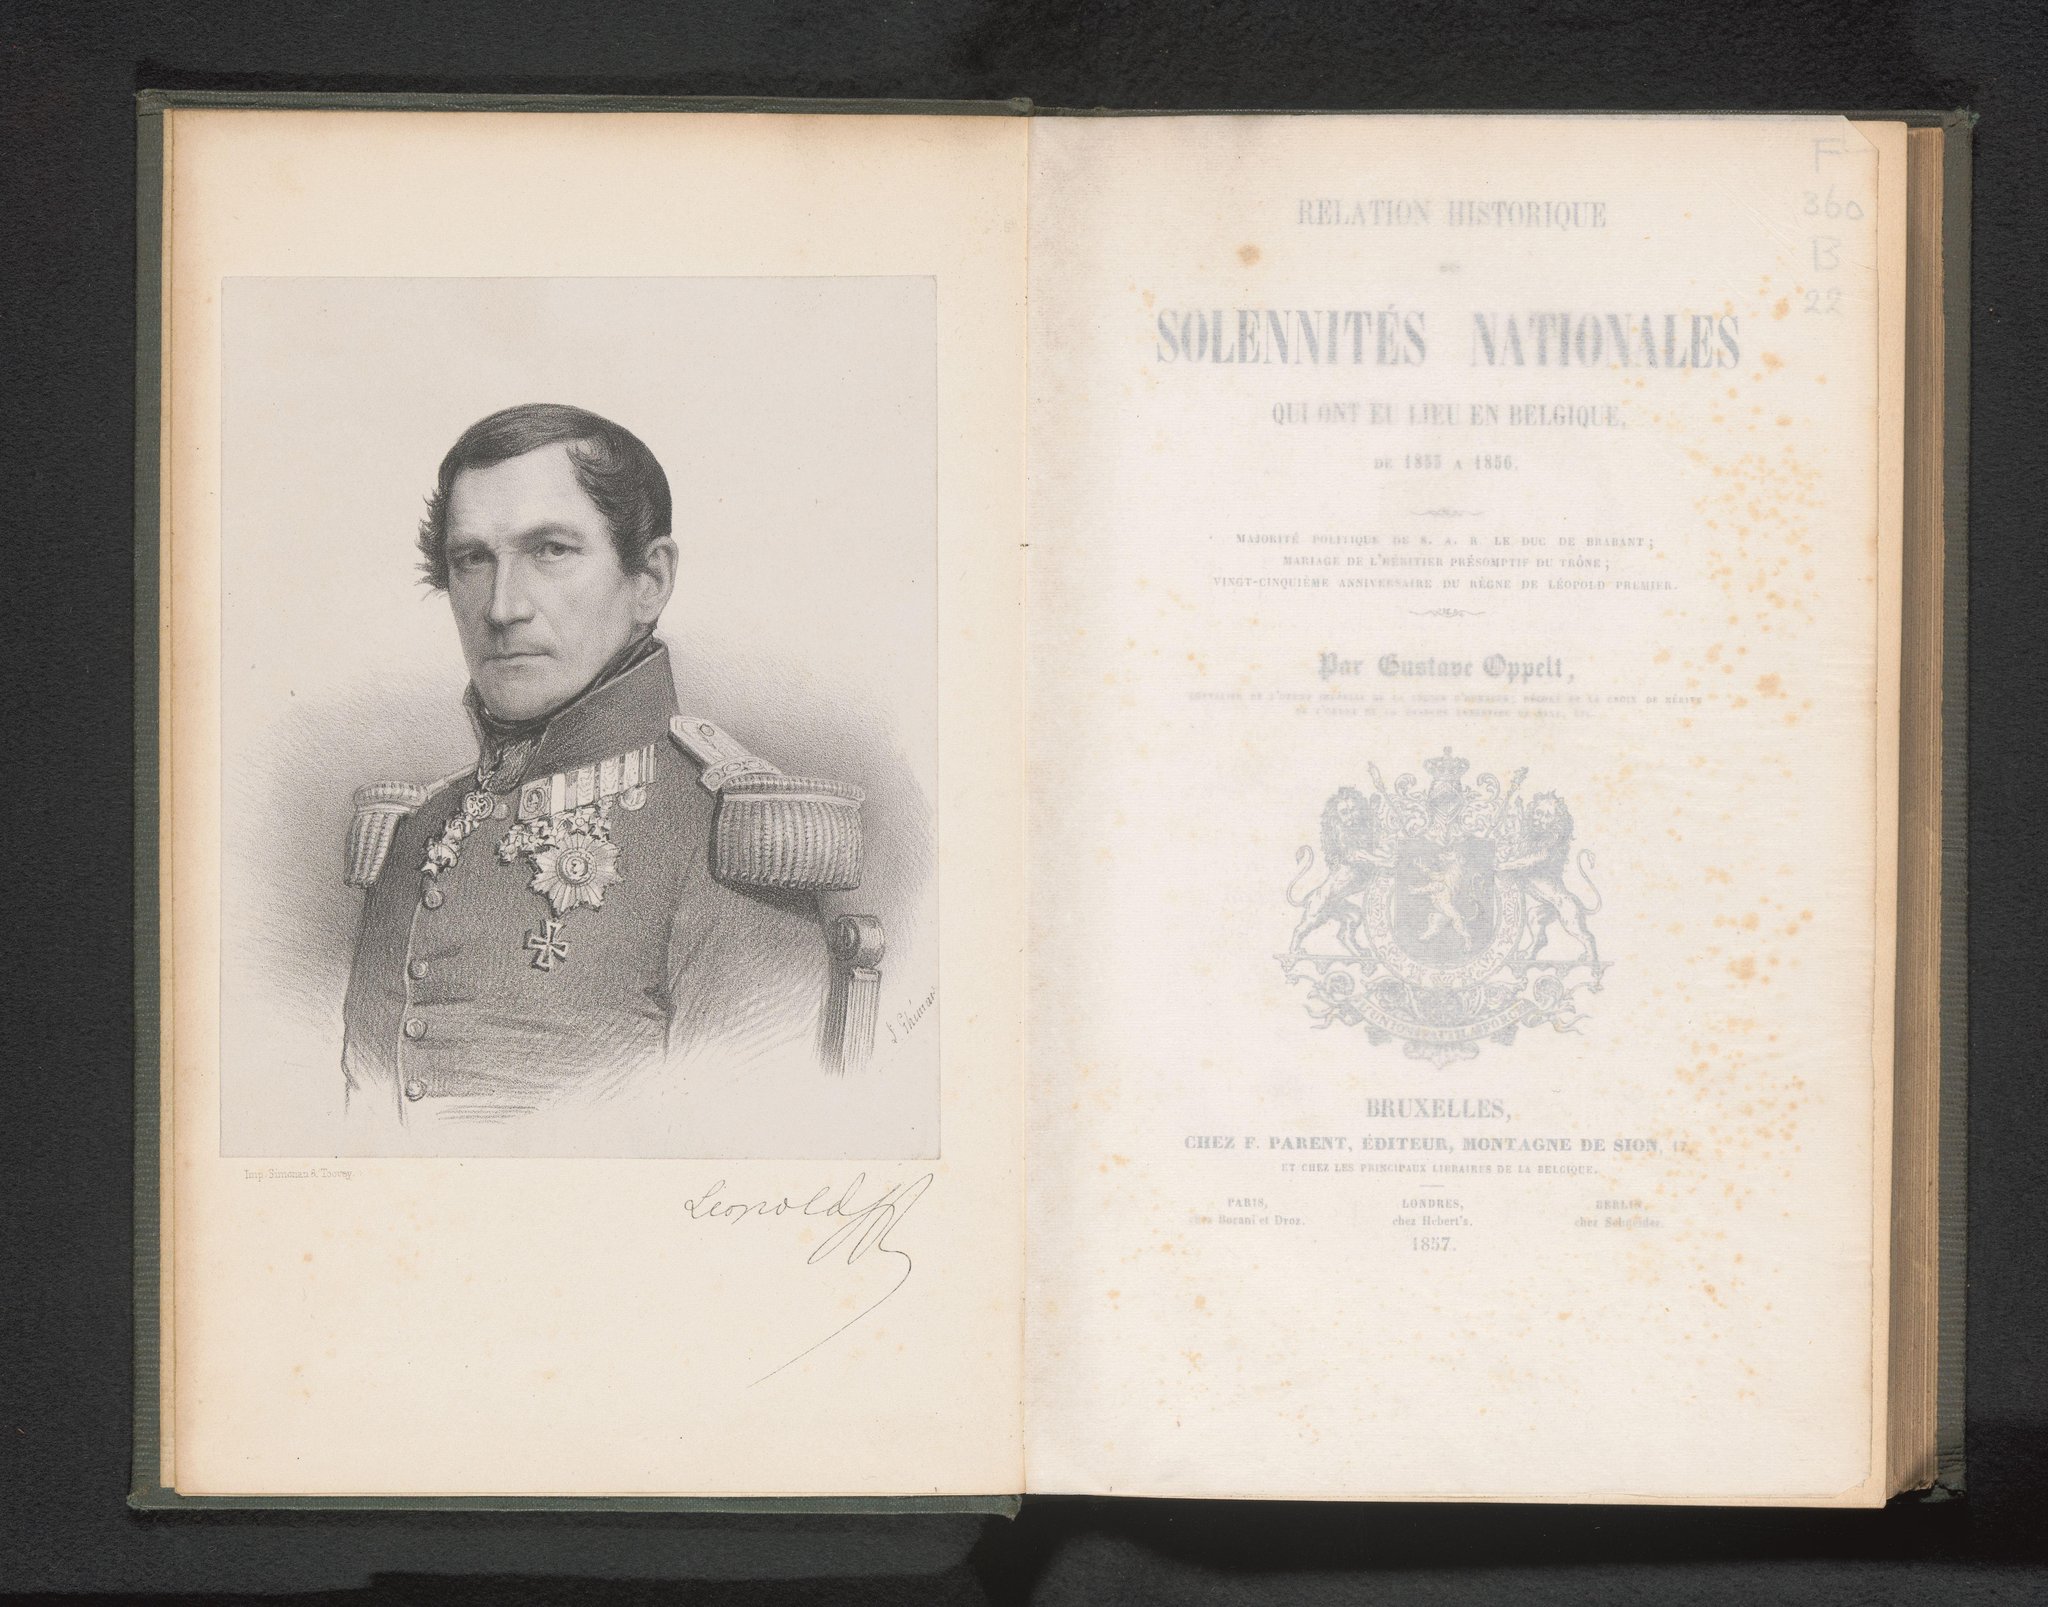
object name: page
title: Reproductie van een foto van een portret van Léopold I, koning van België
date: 1852-1857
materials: paper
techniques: lithograph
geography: brussels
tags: laeken, leopold i (koning der belgen), historical persons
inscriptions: signature: ‘Leopold’